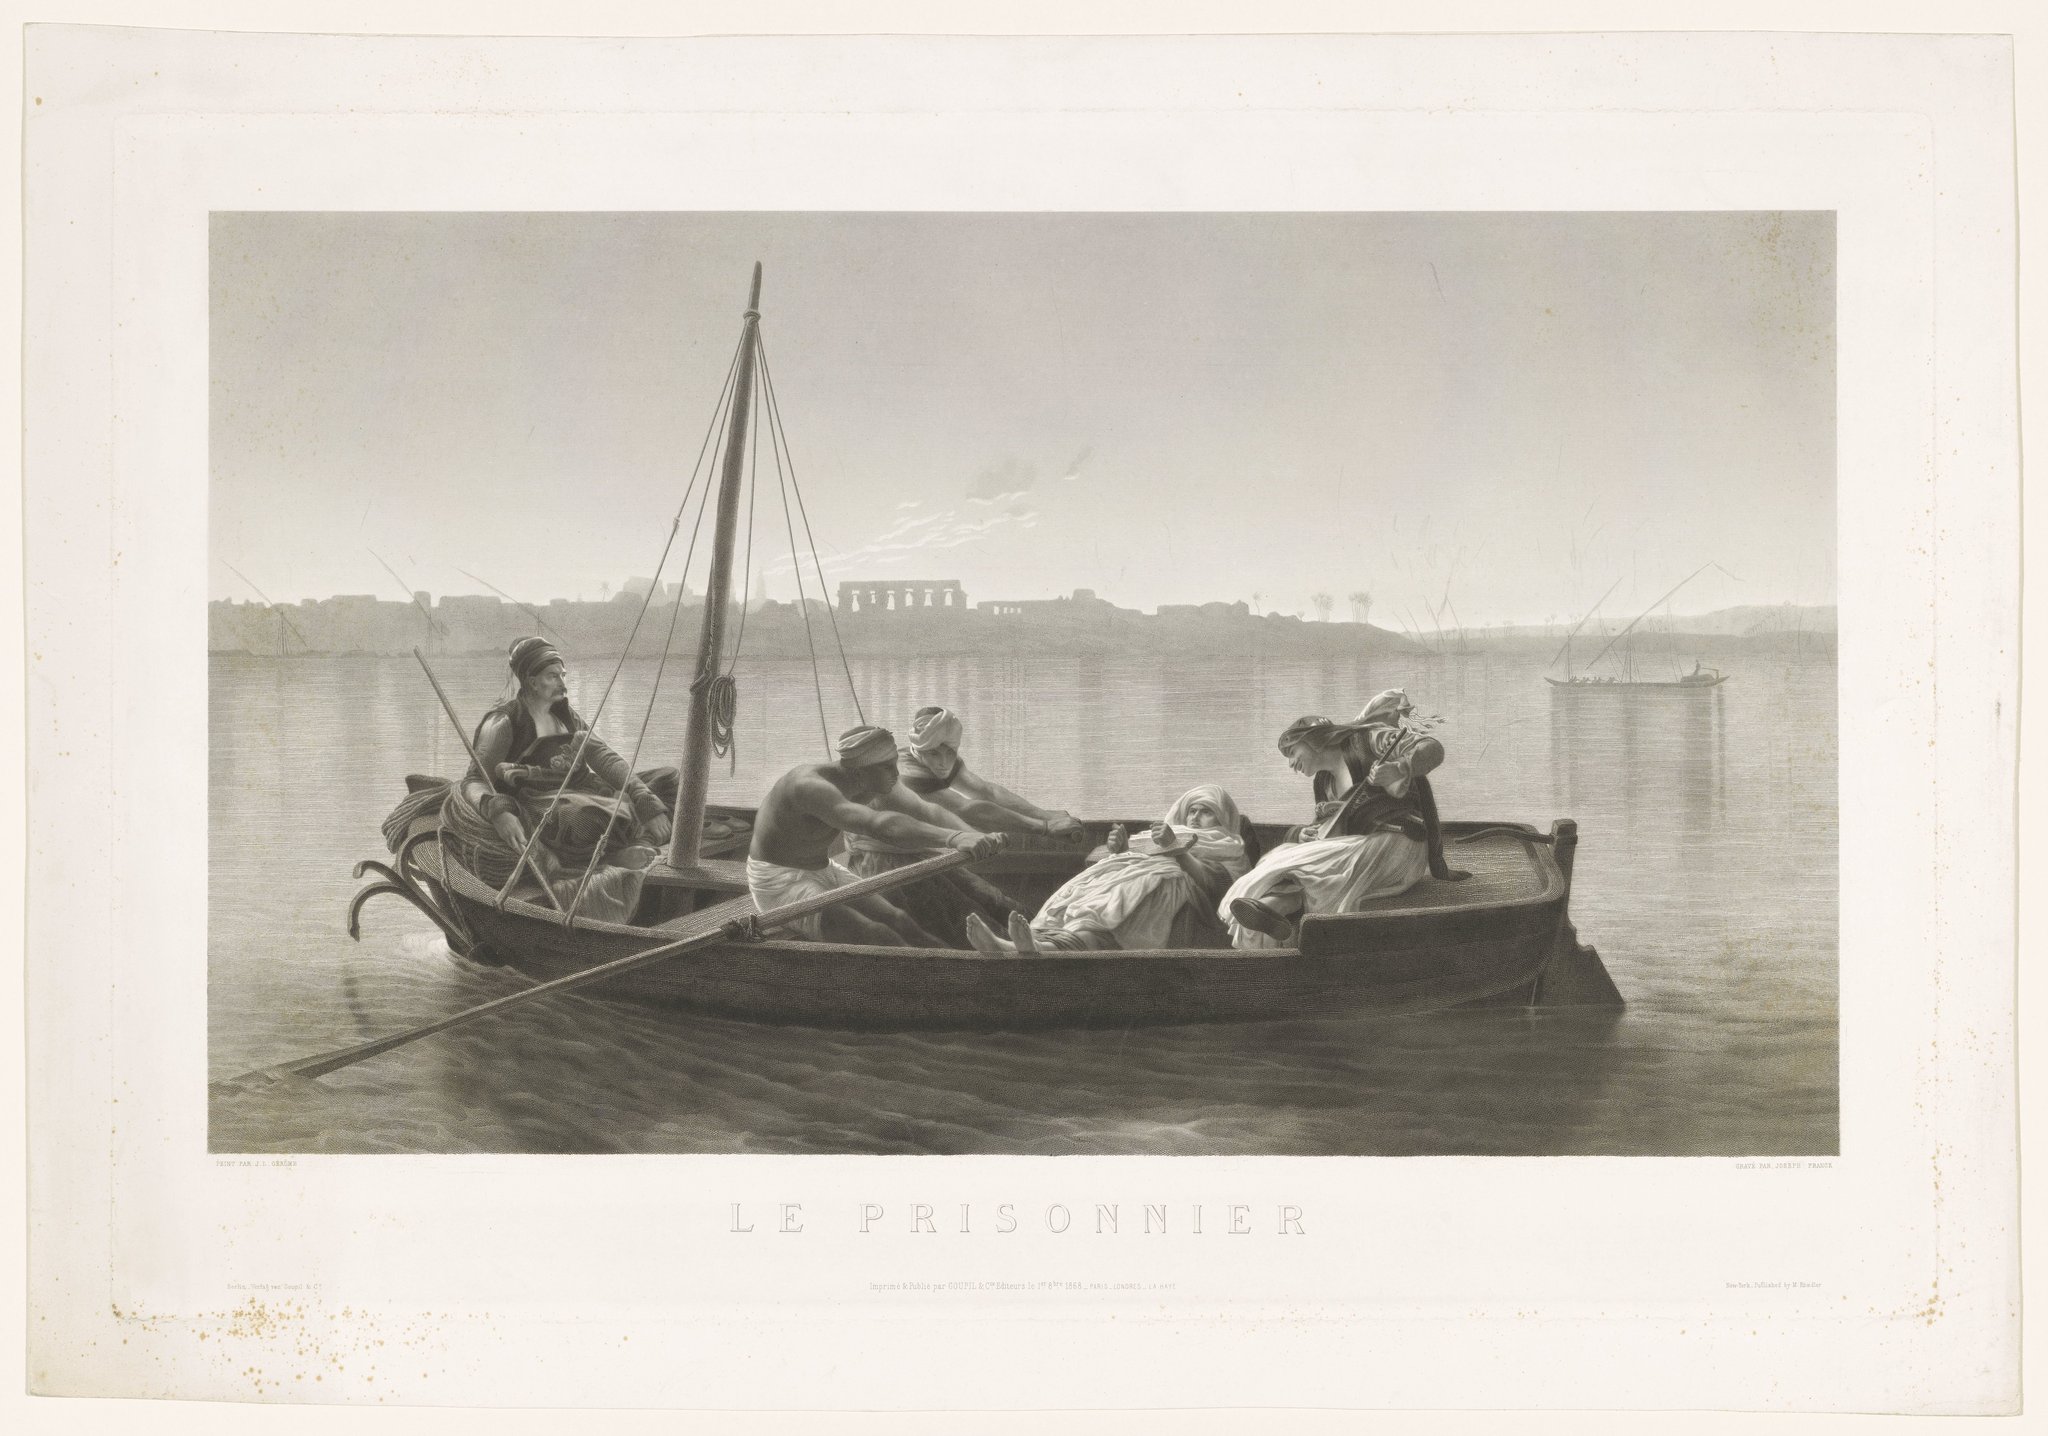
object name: print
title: Gevangene vervoerd op een boot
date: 1861-1878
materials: paper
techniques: engraving, etching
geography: new york city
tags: transfer, deportation ~ prisoner of war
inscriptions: collector's mark: Lugt 2228